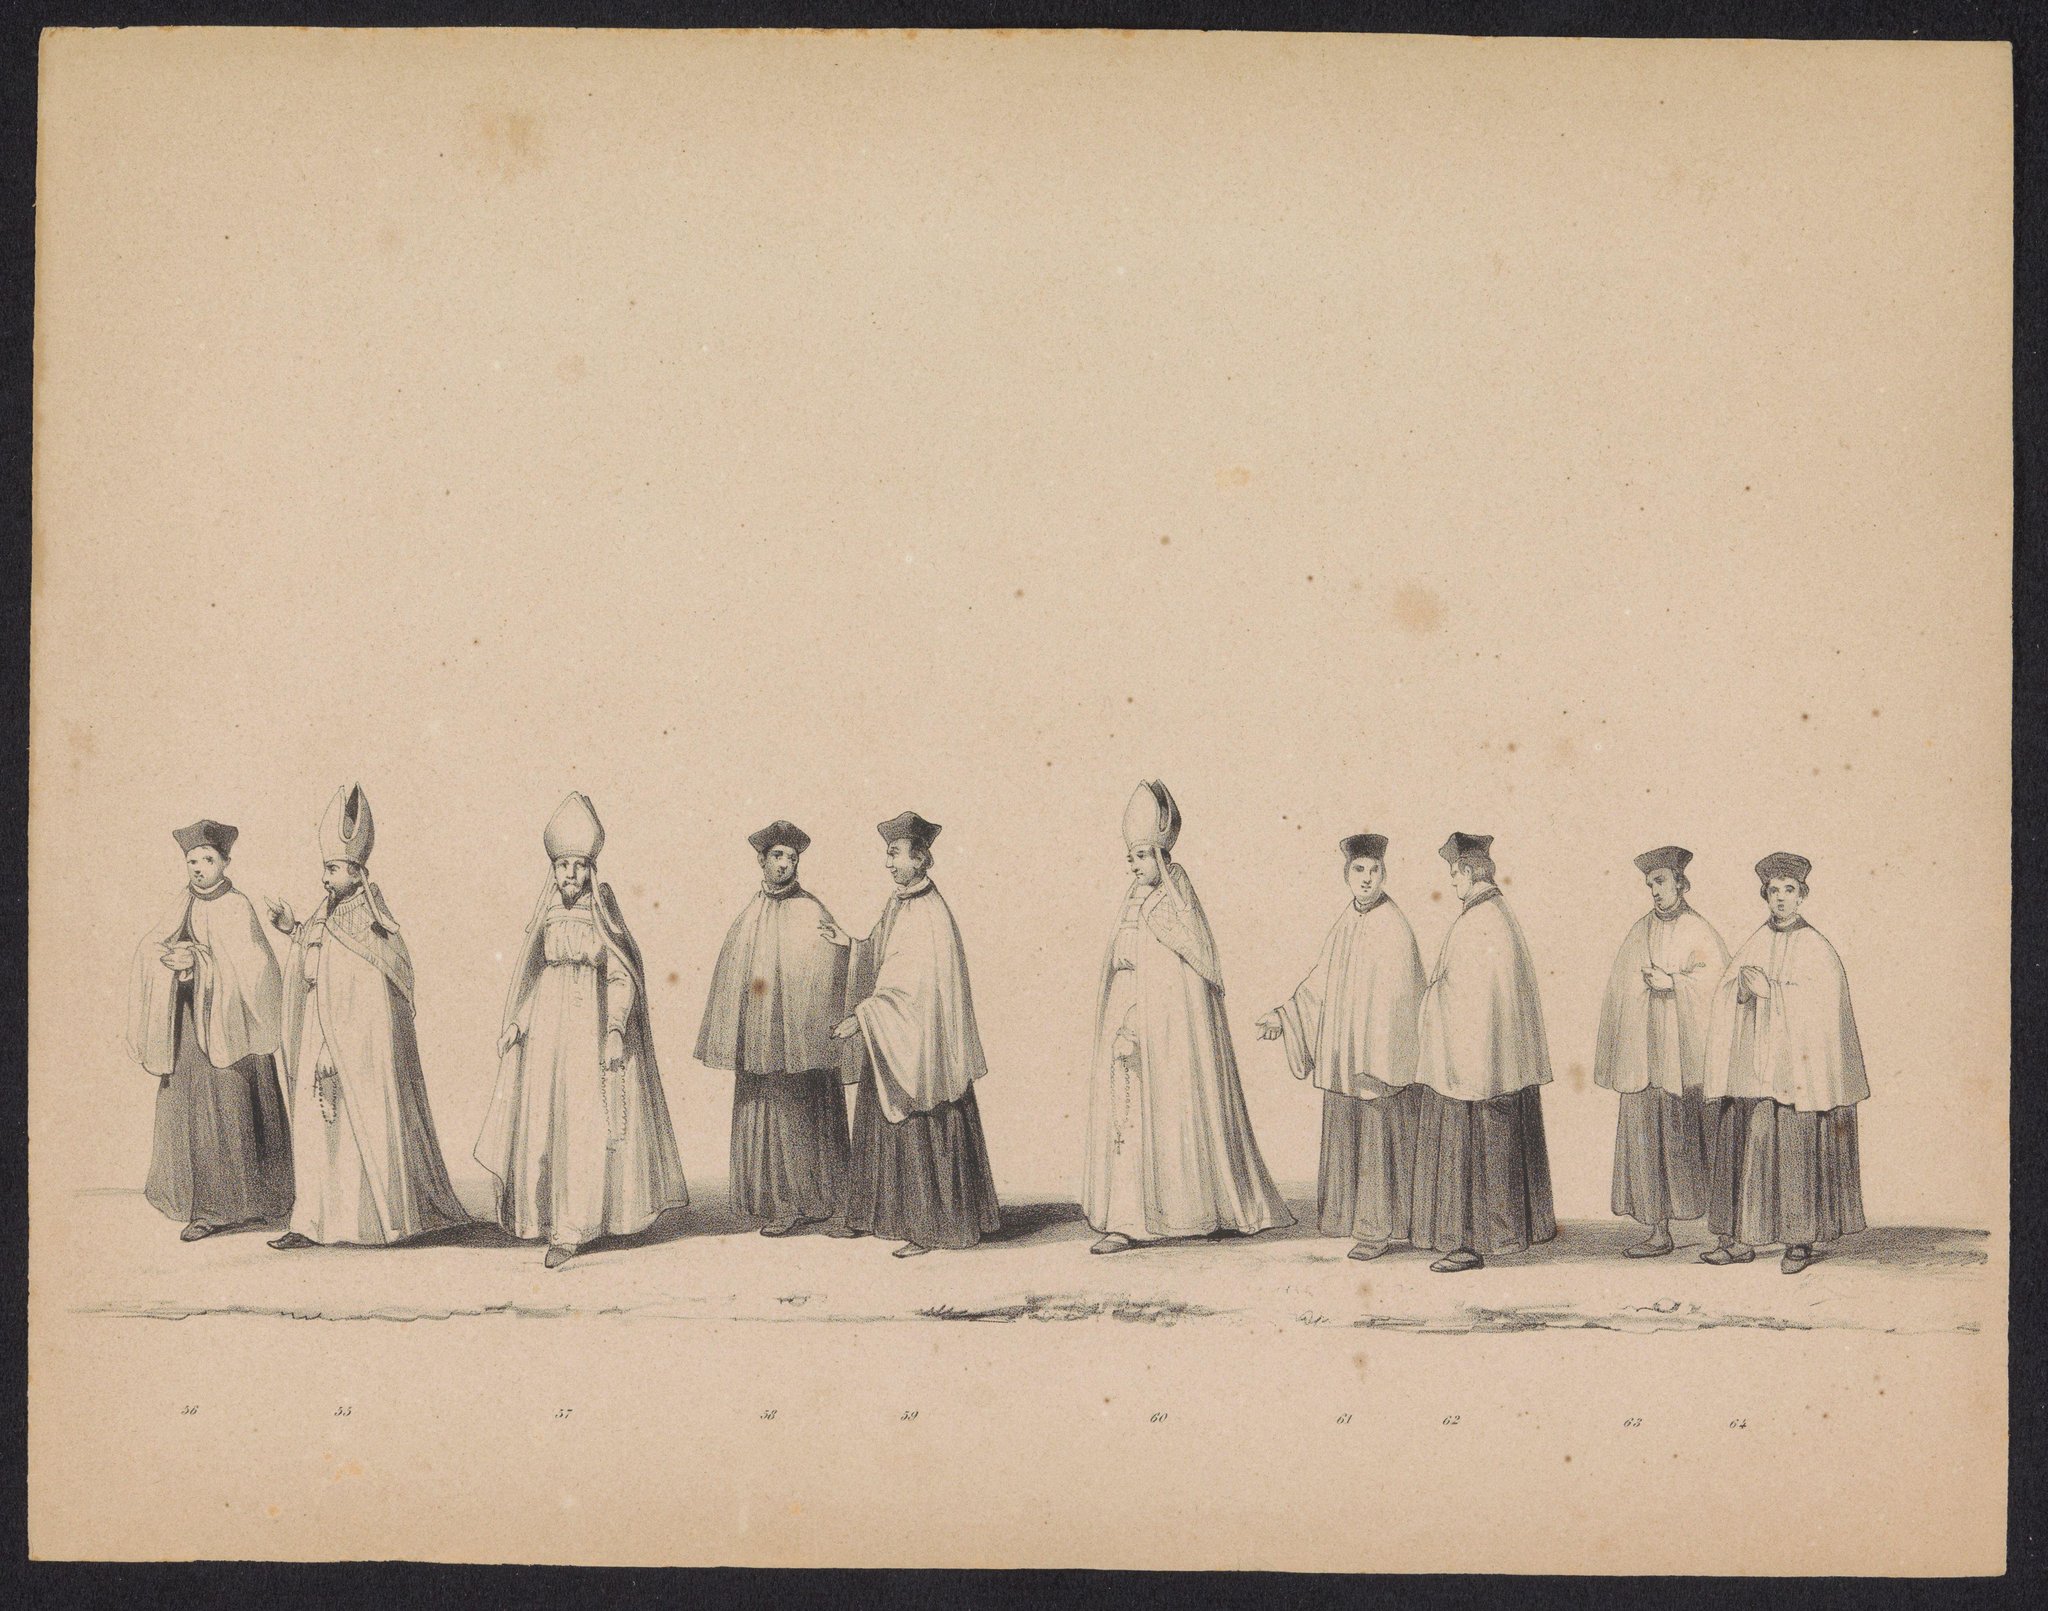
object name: print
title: Afbeelding van den gecostumeerden optogt, voorstellende den in togt van Philips II, Prins van Spanje, in Utrecht, den 3en October 1549, gehouden den 17en Junij 1846, door H.H. Studenten der Utrechtsche Hoogeschool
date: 1847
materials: paper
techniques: lithograph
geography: netherlands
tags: philip ii of spain, students' pageant, costumes used in pageants, utrecht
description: Historische gekostumeerde optocht van de studenten van de Utrechtse Hogeschool gehouden op 17 juni 1846 ter gelegenheid van het 210-jarig bestaan van de Hogeschool. De optocht verbeeldt de intocht van Filips II in Utrecht op 3 oktober 1549. Plaat met de groepen genummerd 55-64. Onderdeel van de serie van 22 aanelkaar te plakken losse bladen.